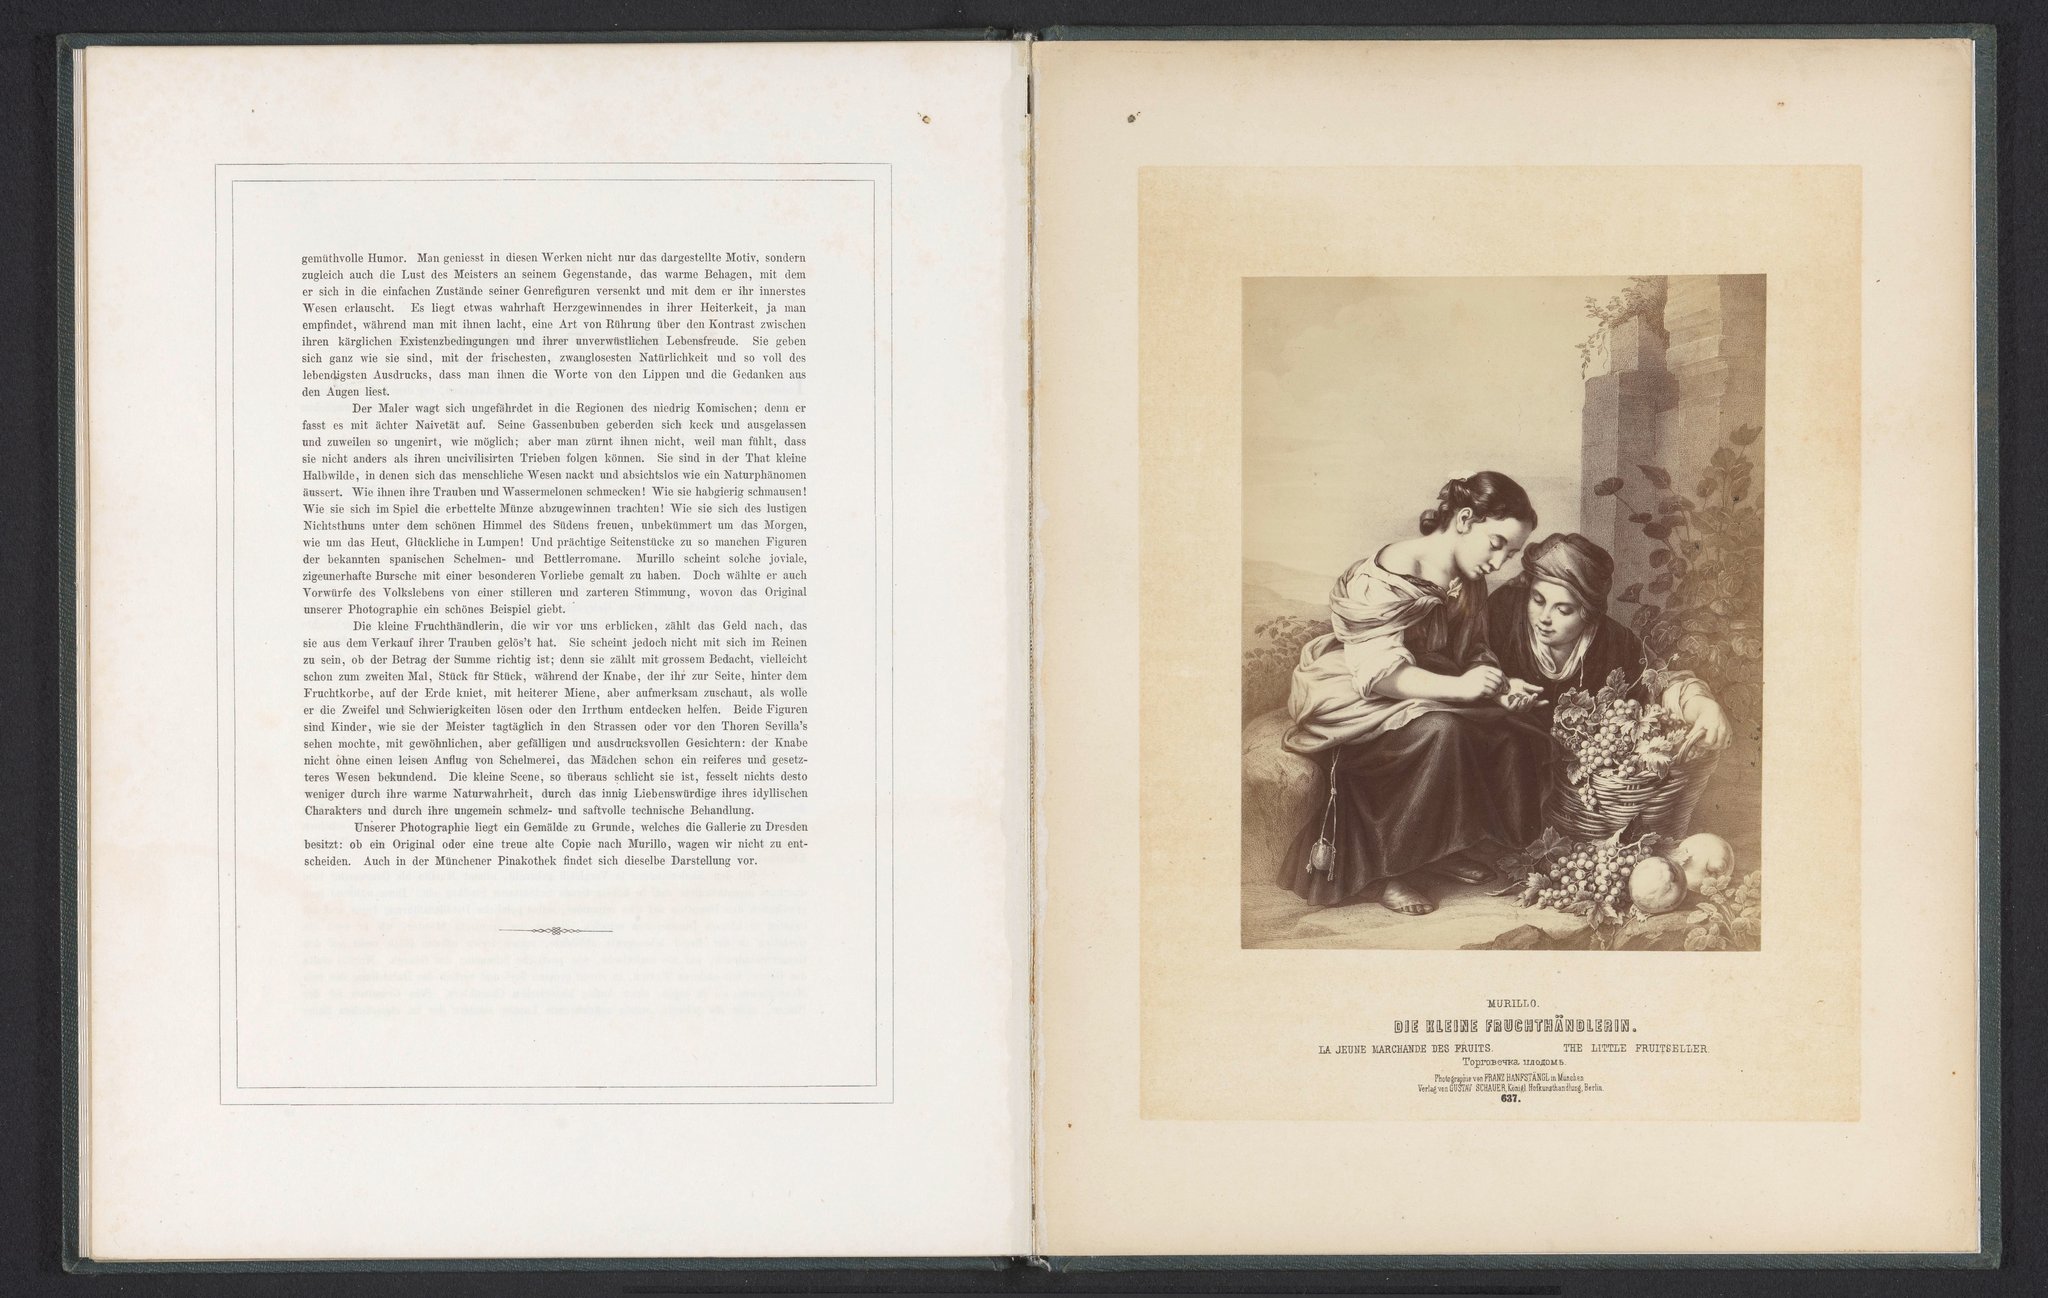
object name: photograph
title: Fotoreproductie van een prent naar een schilderij van een jonge fruithandelaar door Bartolomé Esteban Murillo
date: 1850-1860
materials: photographic support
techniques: albumen print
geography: berlin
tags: street-trader, fruits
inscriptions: number: ‘637.’